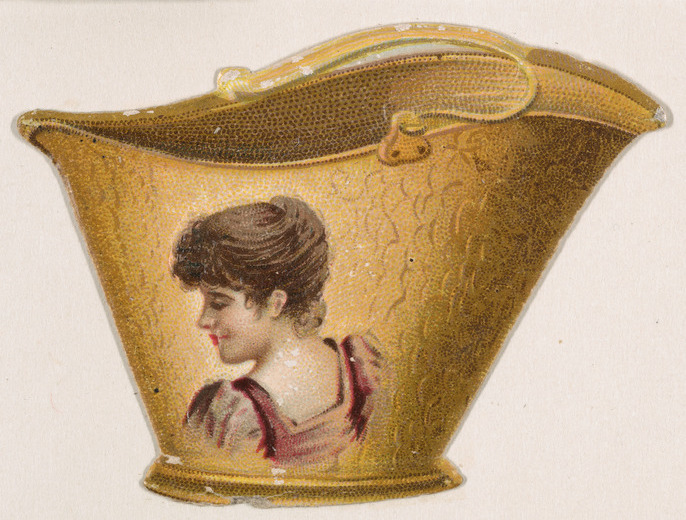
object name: print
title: Coal bucket, from the Novelties series (N228, Type 4) issued by Kinney Bros.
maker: kinney brothers tobacco company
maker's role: publisher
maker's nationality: american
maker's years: 1869-2011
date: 1889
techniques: color lithograph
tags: women,buckets